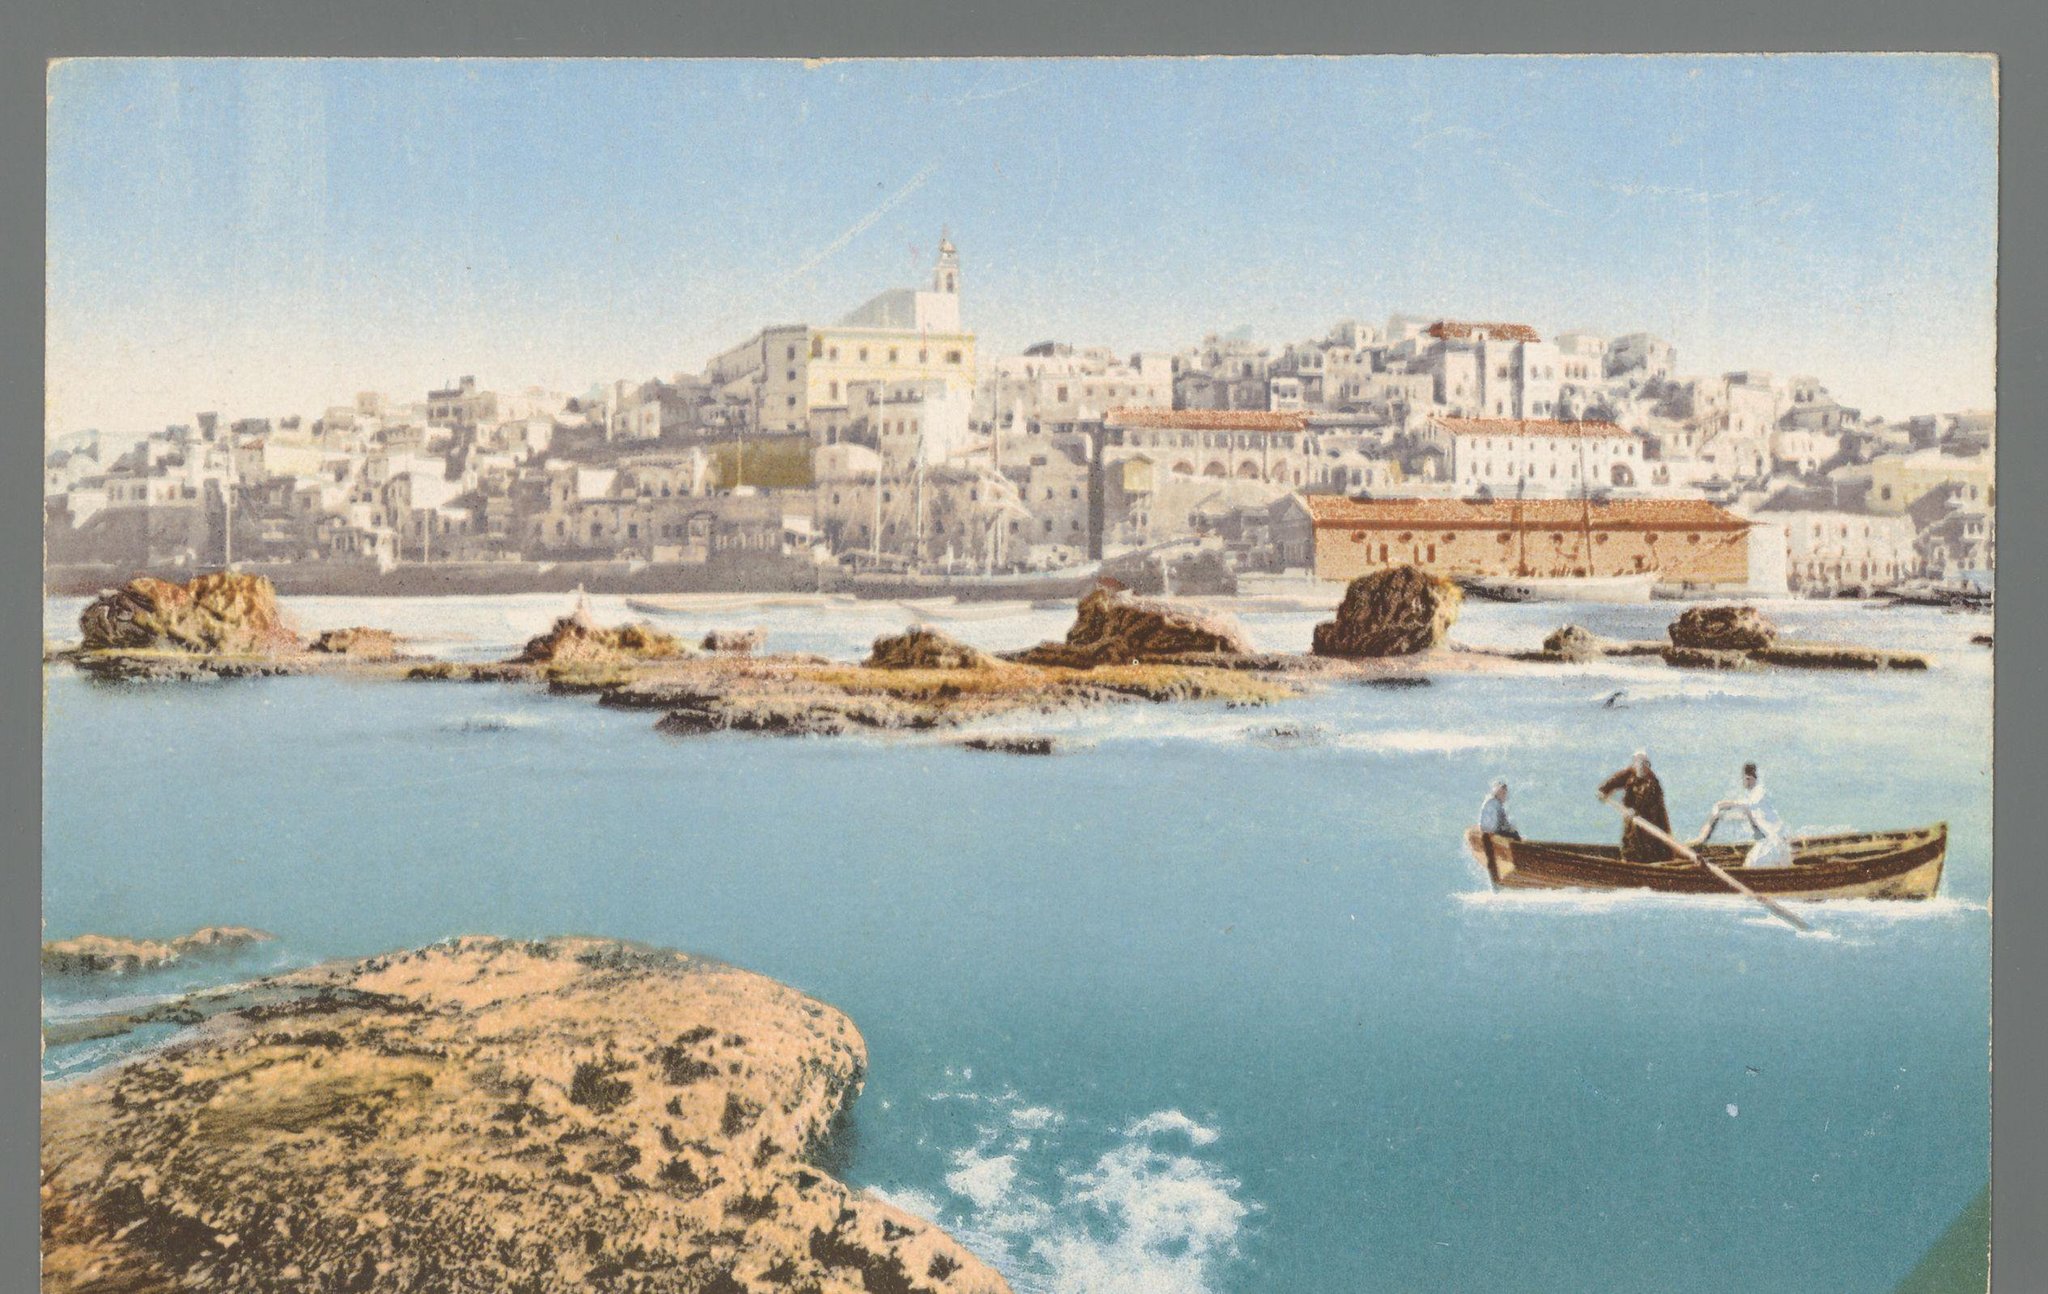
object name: photomechanical print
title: Jaffa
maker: Anonymous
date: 1905-1930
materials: cardboard, photographic process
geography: zurich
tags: city-view, and landscape with man-made constructions, sea